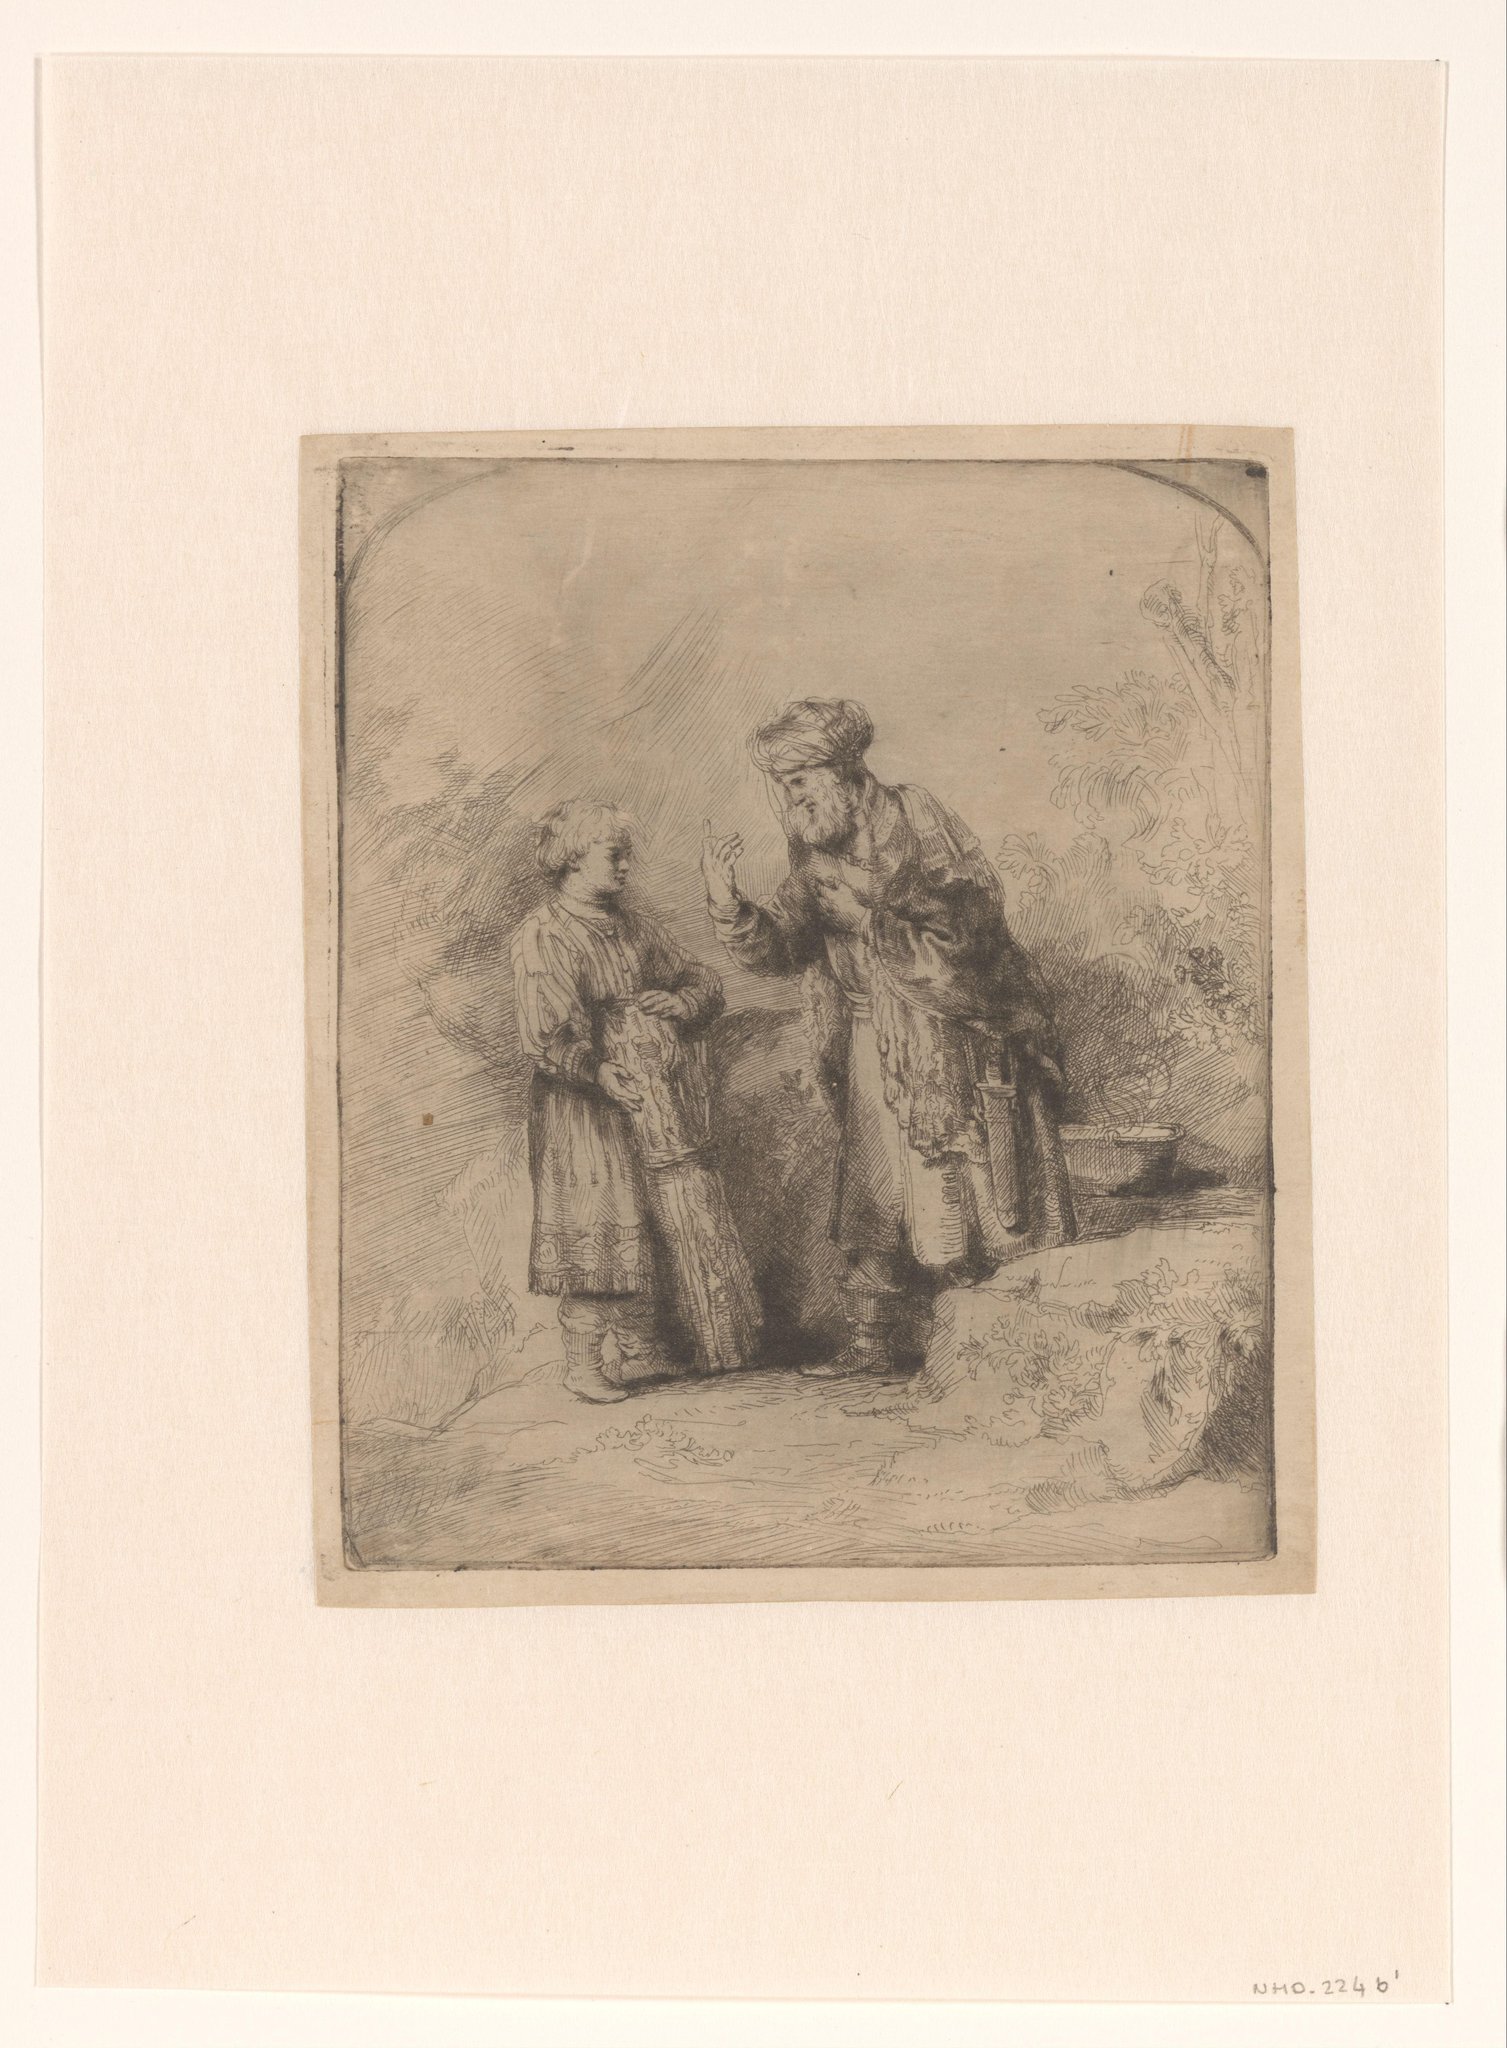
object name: print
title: Abraham and Isaac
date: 1819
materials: paper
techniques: etching, intaglio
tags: story of isaac, story of abraham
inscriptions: collector's mark: Lugt 240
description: Spiegelbeeldige kopie naar de gelijknamige prent van Rembrandt. Prent voor het eerst gebruikt in: Recueil de Quatre-Vingt-Cinq estampes originales, têtes, paysages et différens sujets, dessinées et gravées par Rembrandt. Parijs: Henry Louis Basan, 1819.